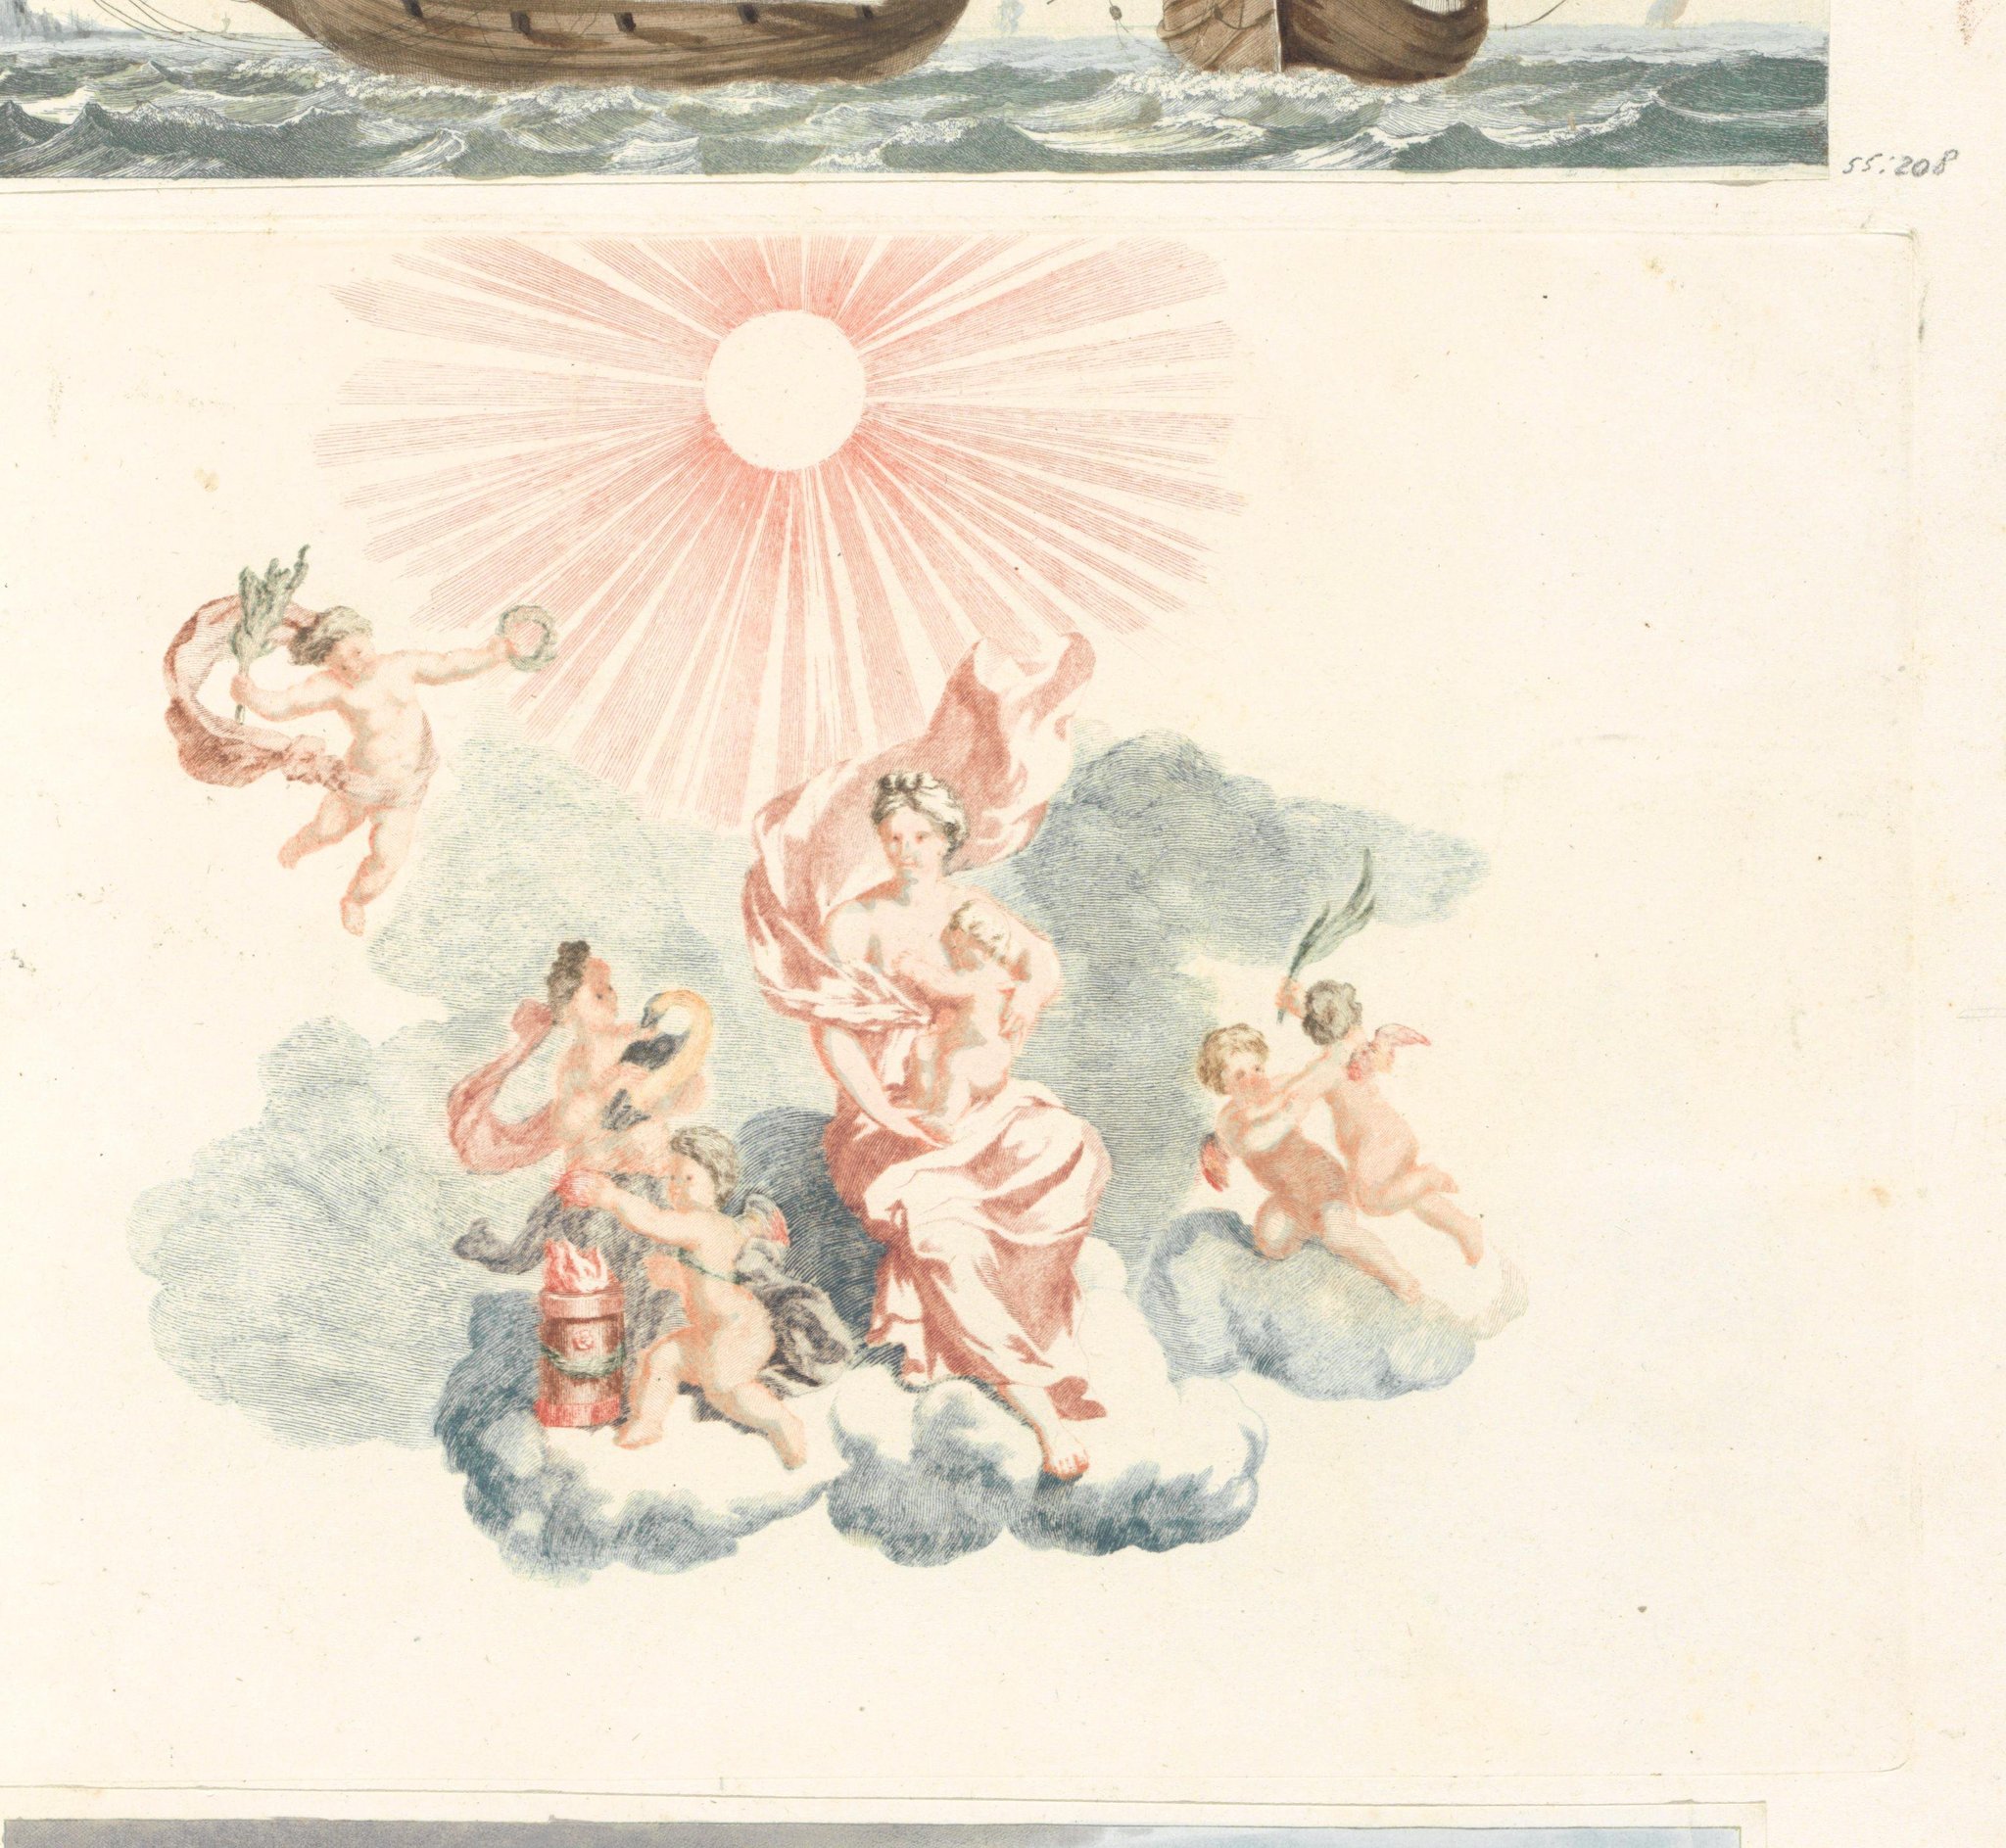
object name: print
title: Zeilschepen op zee voor Istanbul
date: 1665-1698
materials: paper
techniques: etching, hand coloring, lithography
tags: sailing-ship, sailing-boat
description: Twee zeilschepen op zee, mogelijk voor de kust van Istanbul. Deze prent maakt deel uit van een album.